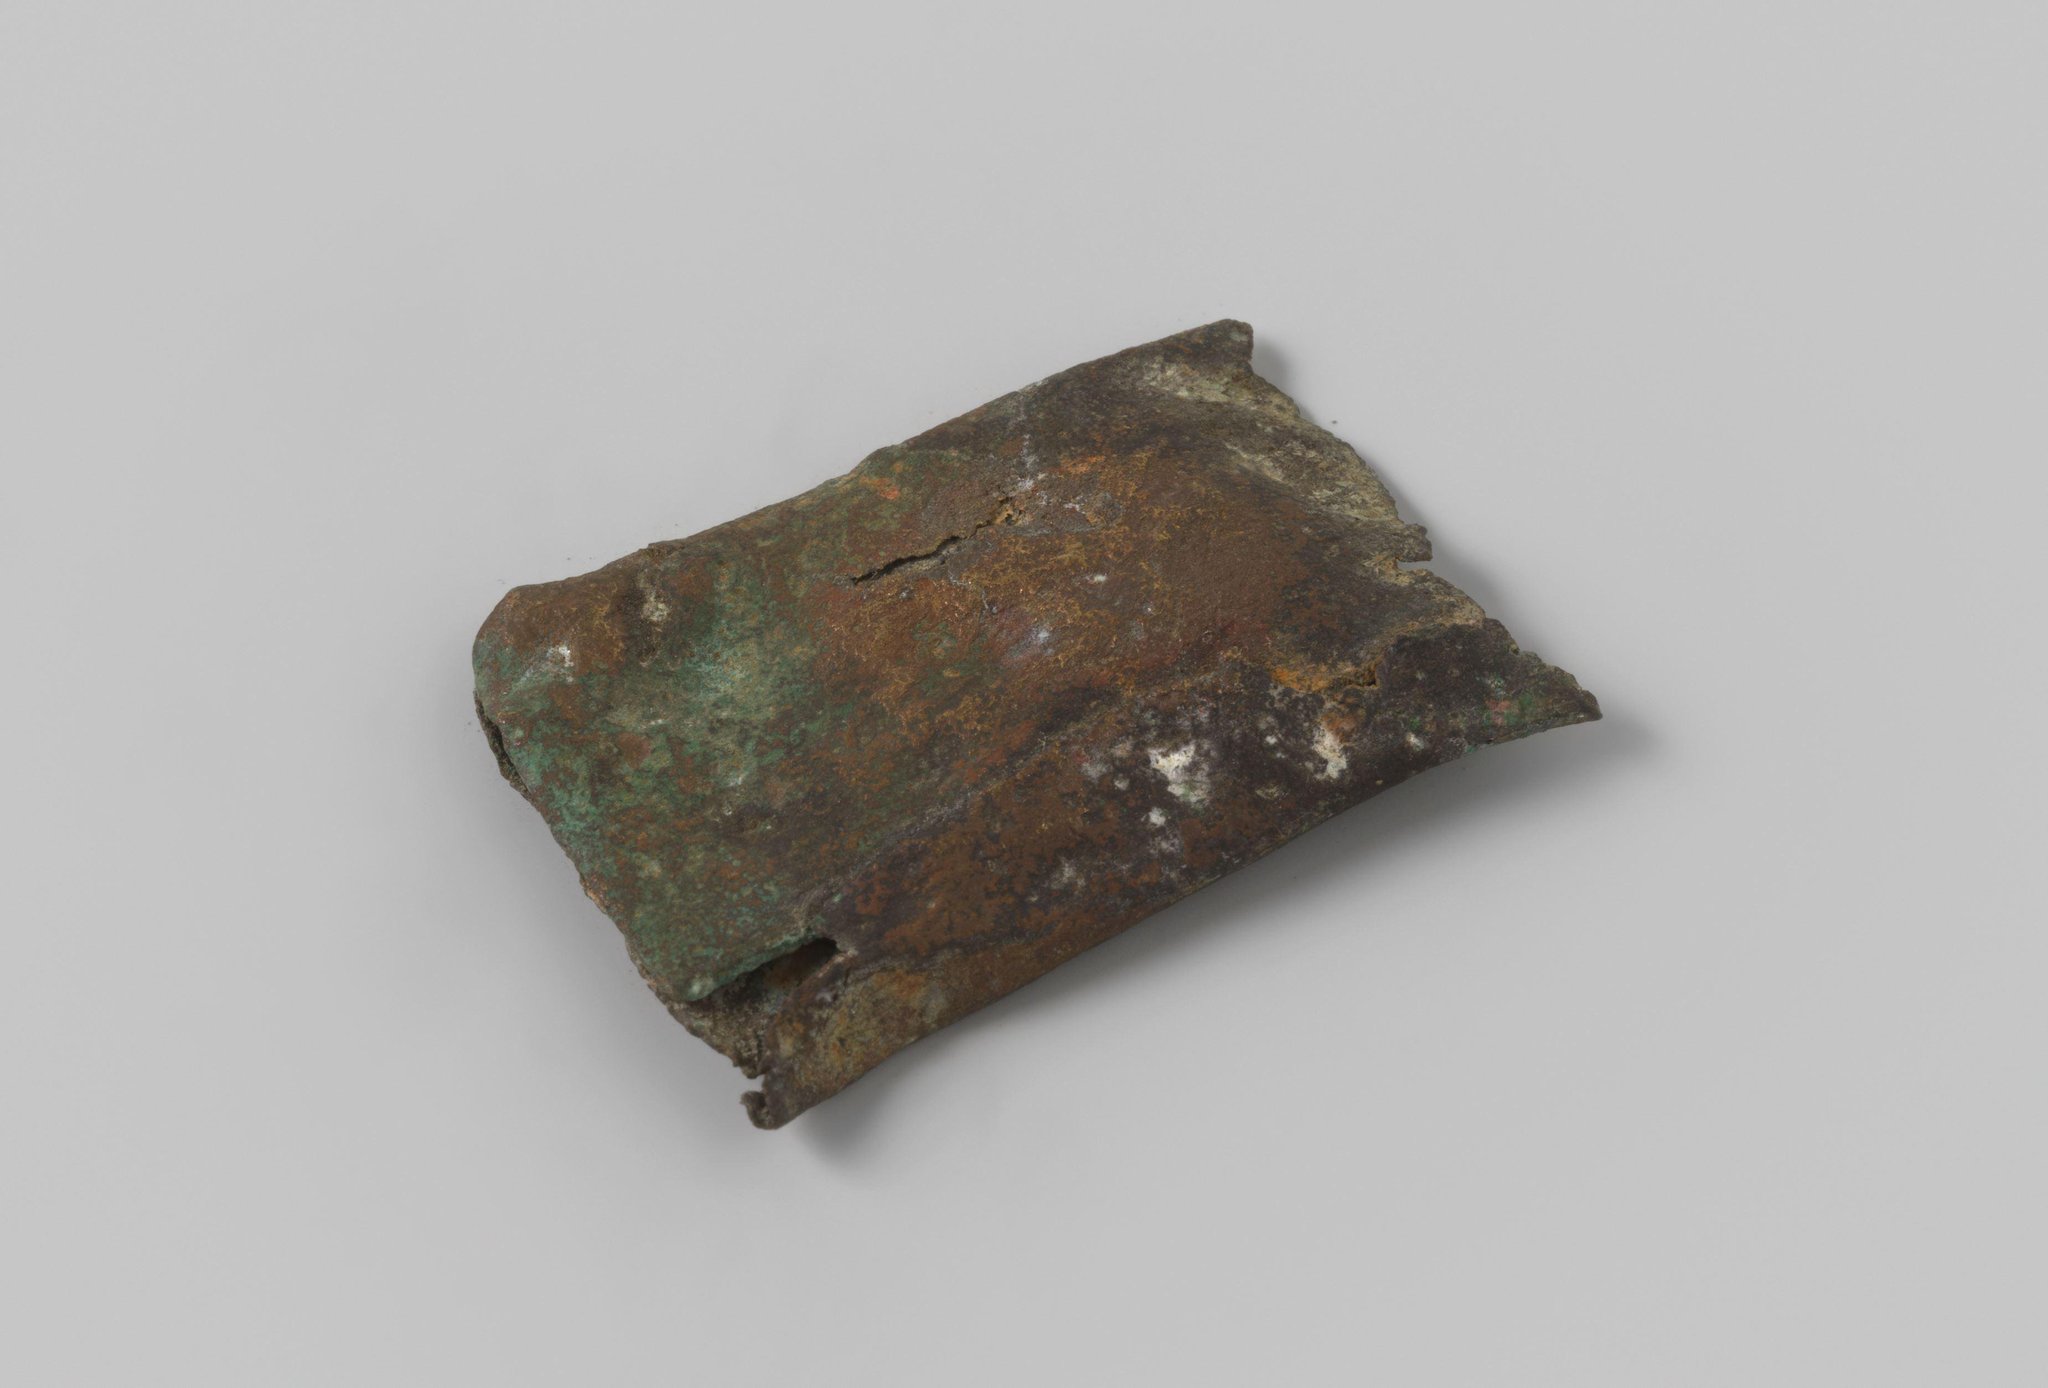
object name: cartridge shell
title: Fragment patroonhuls uit het wrak van de Oost-Indiëvaarder Hollandia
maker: Anonymous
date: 1700-1743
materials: copper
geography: netherlands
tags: verenigde oostindische compagnie, hollandia (schip), annet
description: Cartridge case, tube; fragm, squashed, id. NG 1979-205H549.